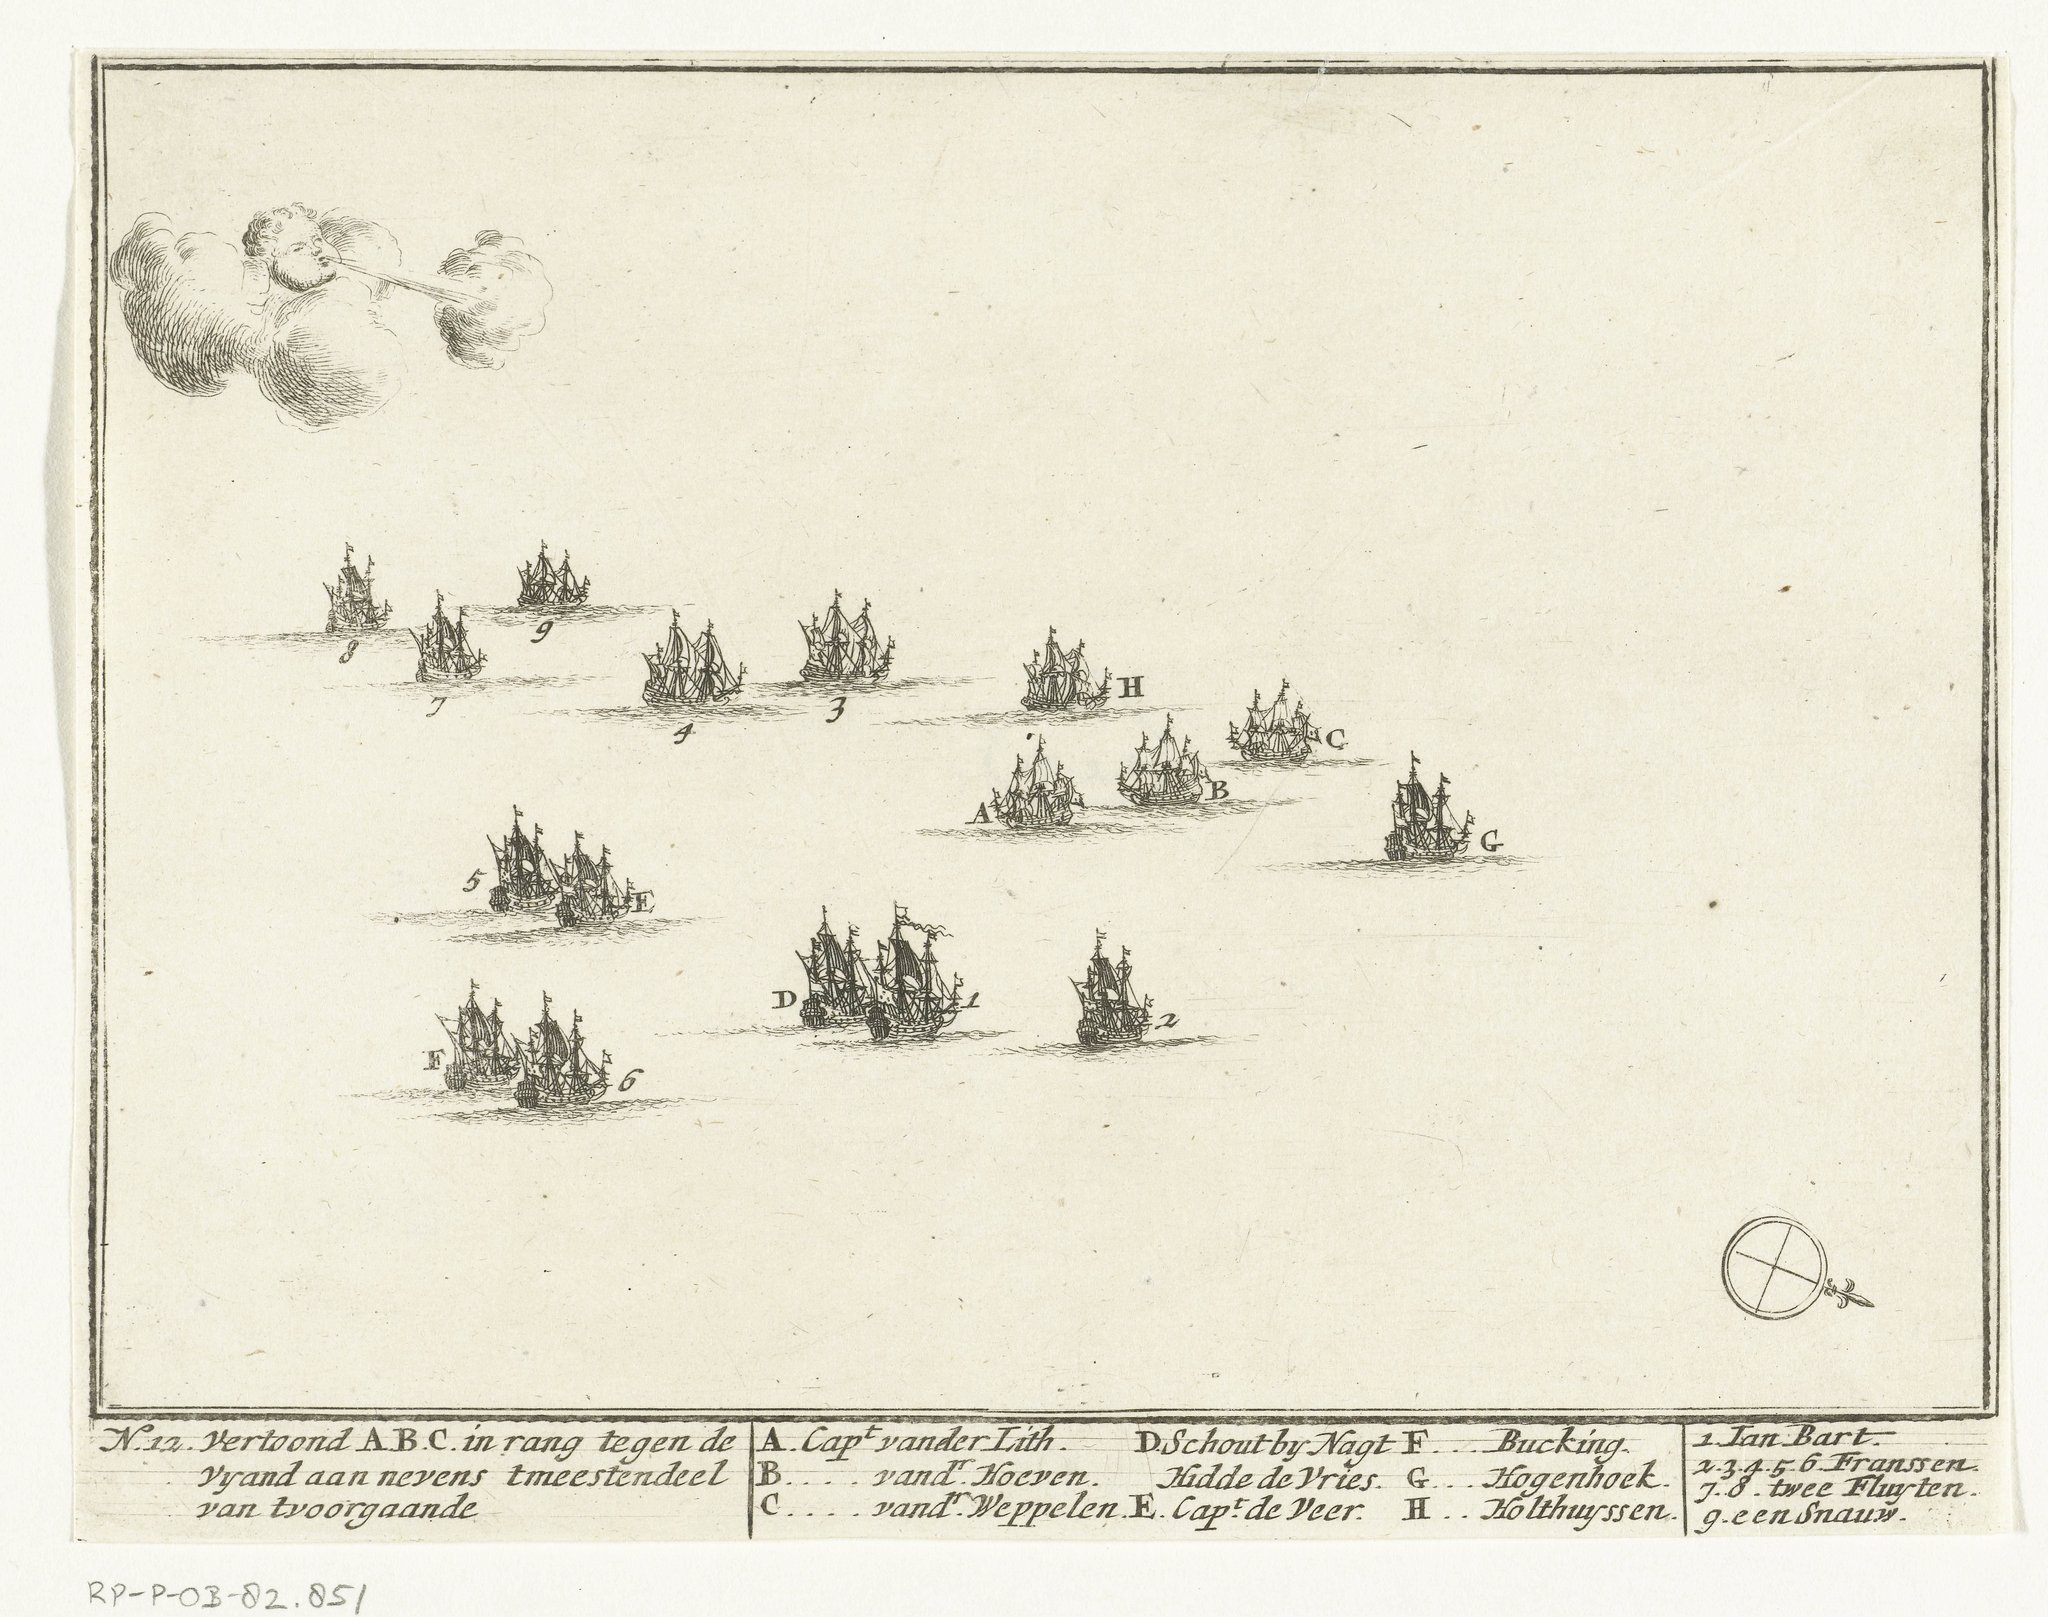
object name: print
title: Zeegevecht tussen Hollanders en Fransen op de Noordzee (plaat 12), 1694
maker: adriaen schoonebeek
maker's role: print maker, publisher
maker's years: 1661-1705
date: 1694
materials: paper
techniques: etching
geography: amsterdam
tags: battle (+ naval force)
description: Zeegevecht tussen Hollanders en Fransen op de Noordzee. Plaat nr. 12 in een serie van 14 genummerde platen van een zeegevecht voorgevallen tussen een Hollands eskader onder Hidde Sjoerds de Vries en Franse schepen onder Jan Bart op de Noordzee, 29 juni 1694.